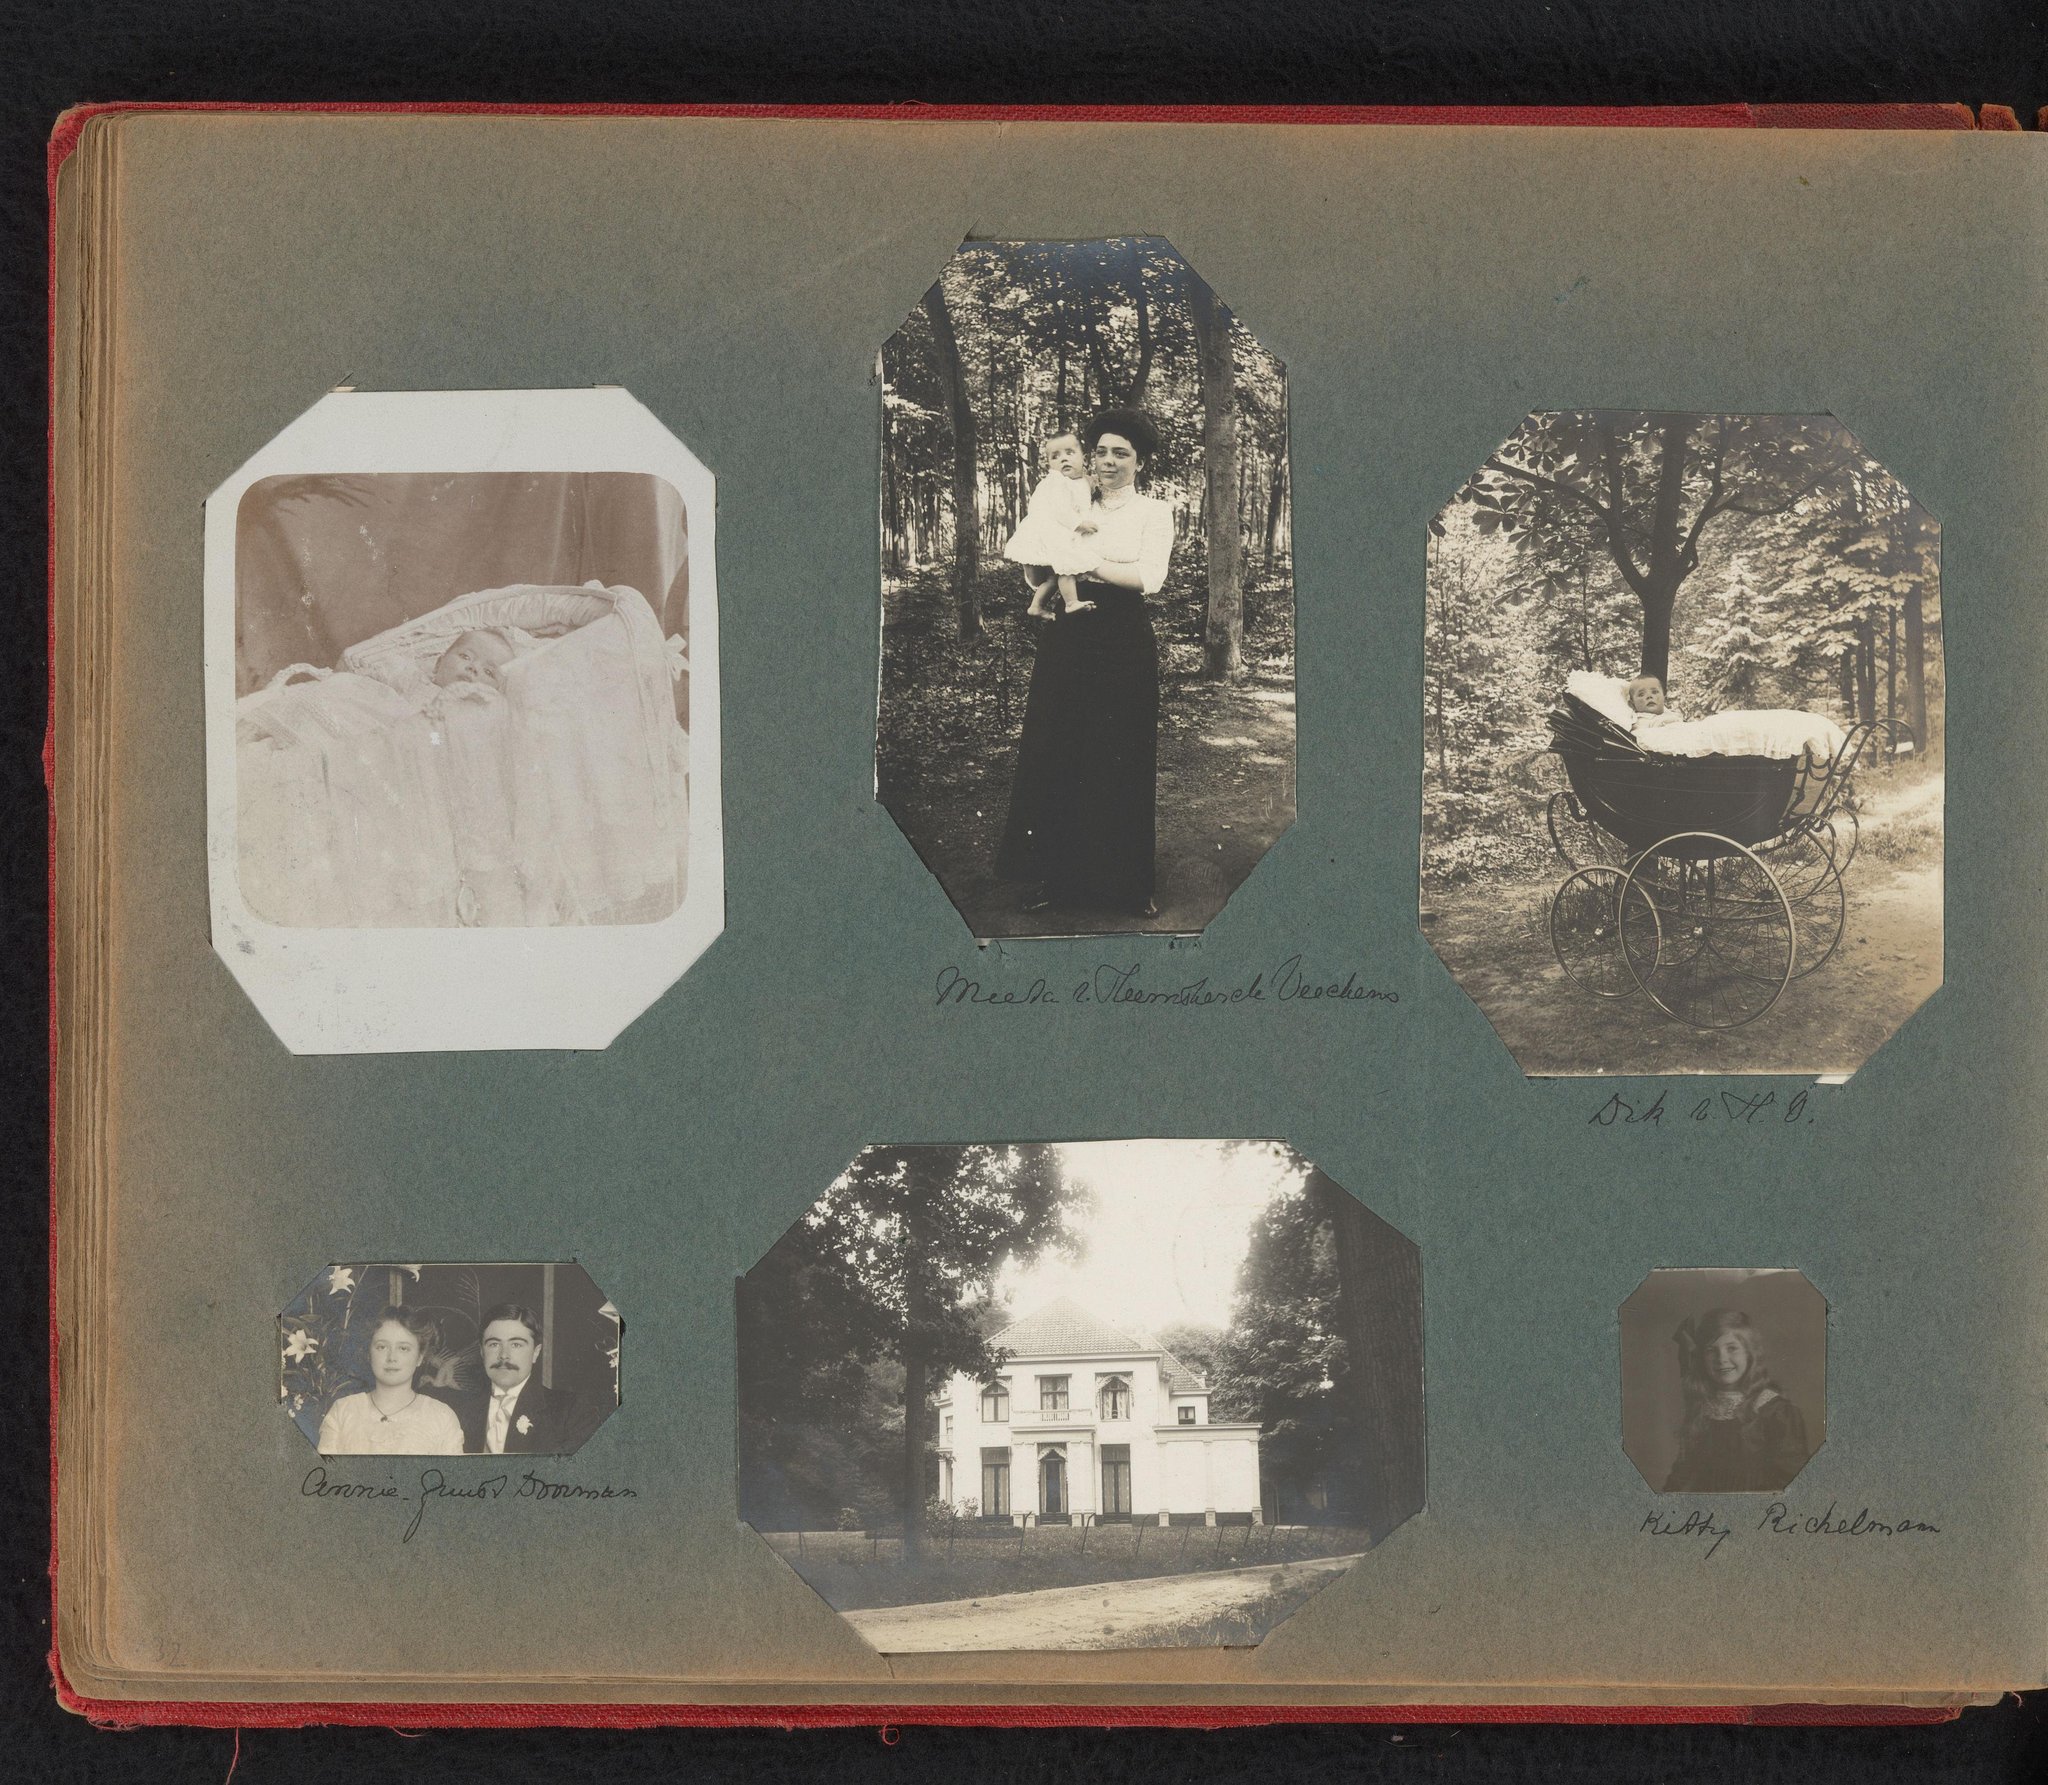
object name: snapshot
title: Vijf portretten van familieleden en kennissen van Charlotte Boelen-Matthes, waaronder een snelfoto van Kitty Richelmann, en een gezicht op een villa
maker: charlotte alida boelen-matthes (lot)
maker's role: amateurfotograaf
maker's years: 1889-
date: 1912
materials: paper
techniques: gelatin silver print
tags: anonymous historical person portrayed, villa, australia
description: Deze foto's zijn onderdeel van een album.